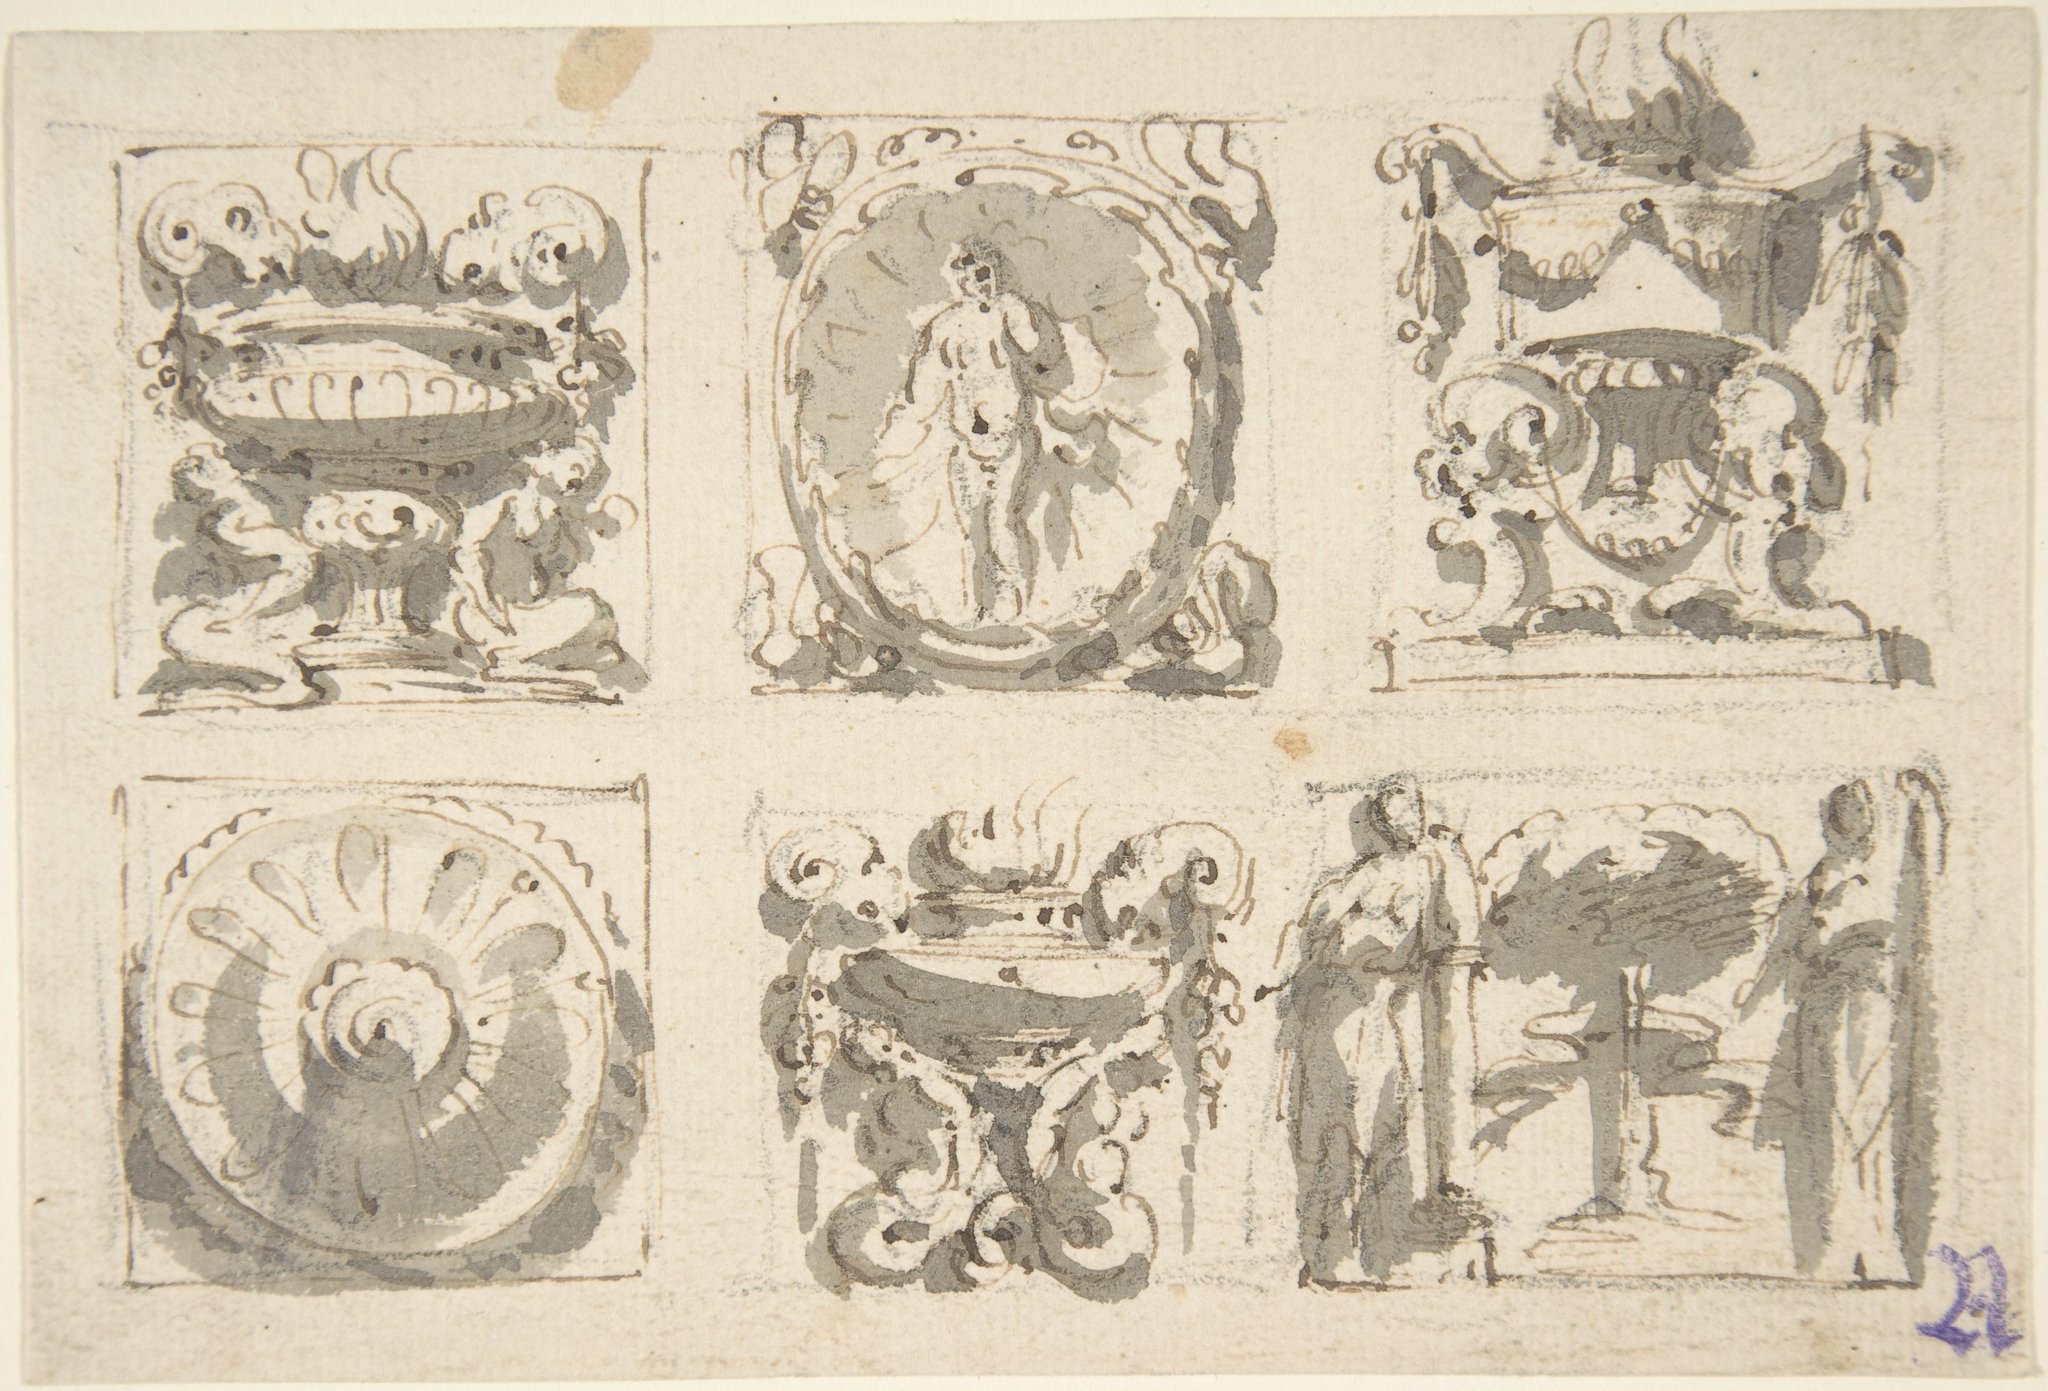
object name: drawing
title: Six Designs for the Decoration of Rectangular and Horizontal reliefs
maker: giuseppe bernardino bison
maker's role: artist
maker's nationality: italian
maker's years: 1762-1844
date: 1782-1844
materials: chalk, ink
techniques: brush, pen, wash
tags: ornament